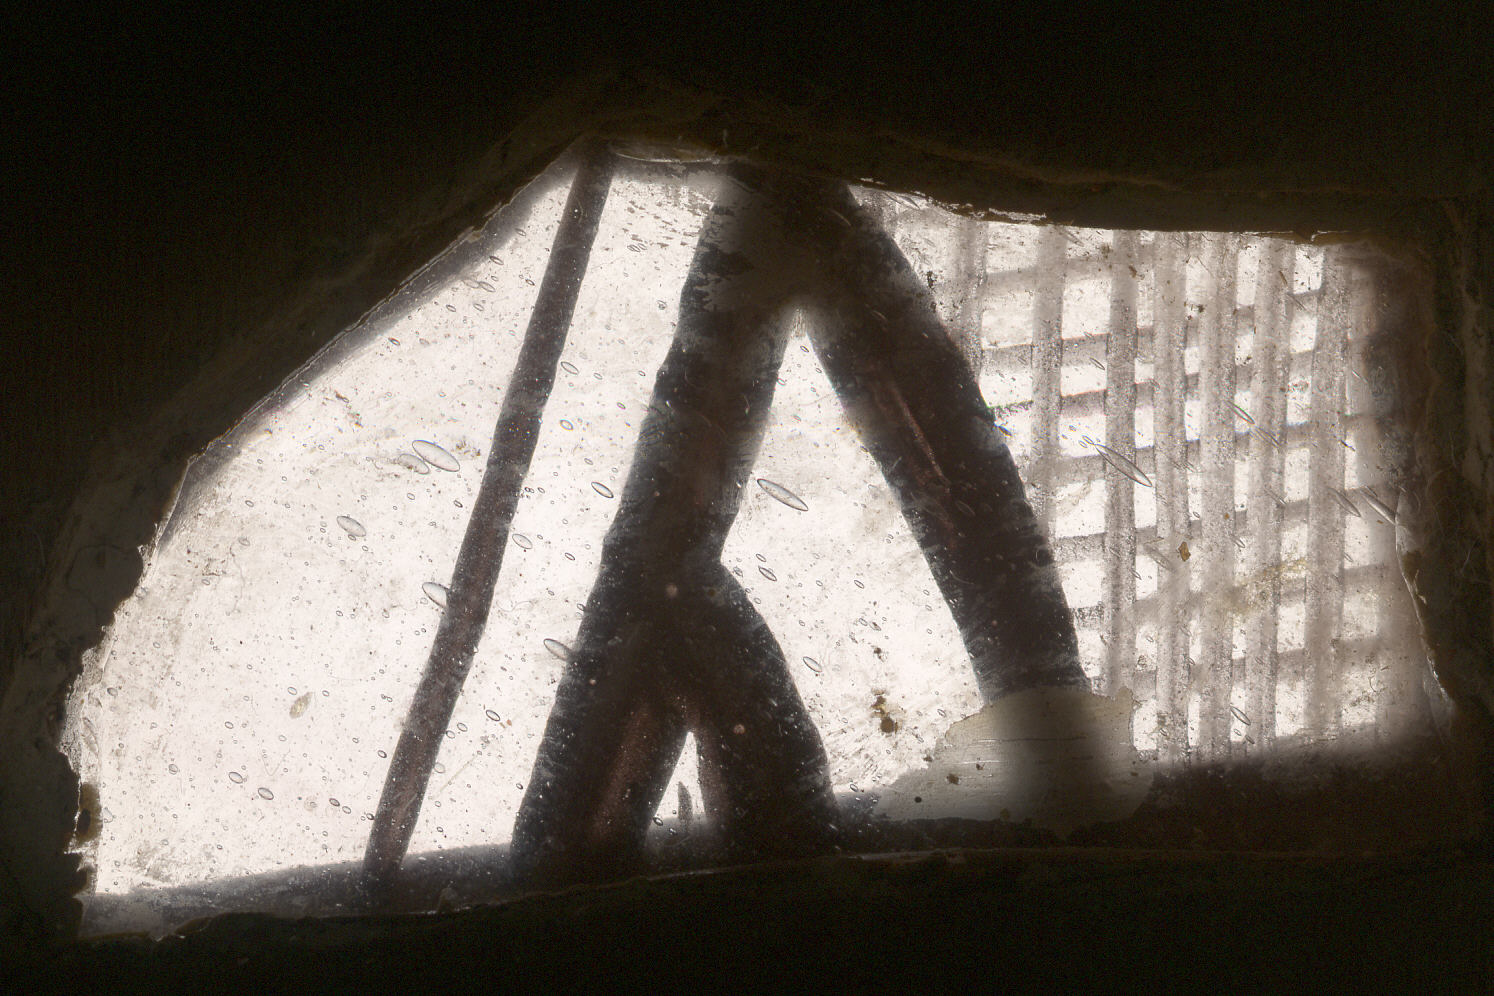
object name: fragment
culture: crusader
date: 1201-1300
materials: glass